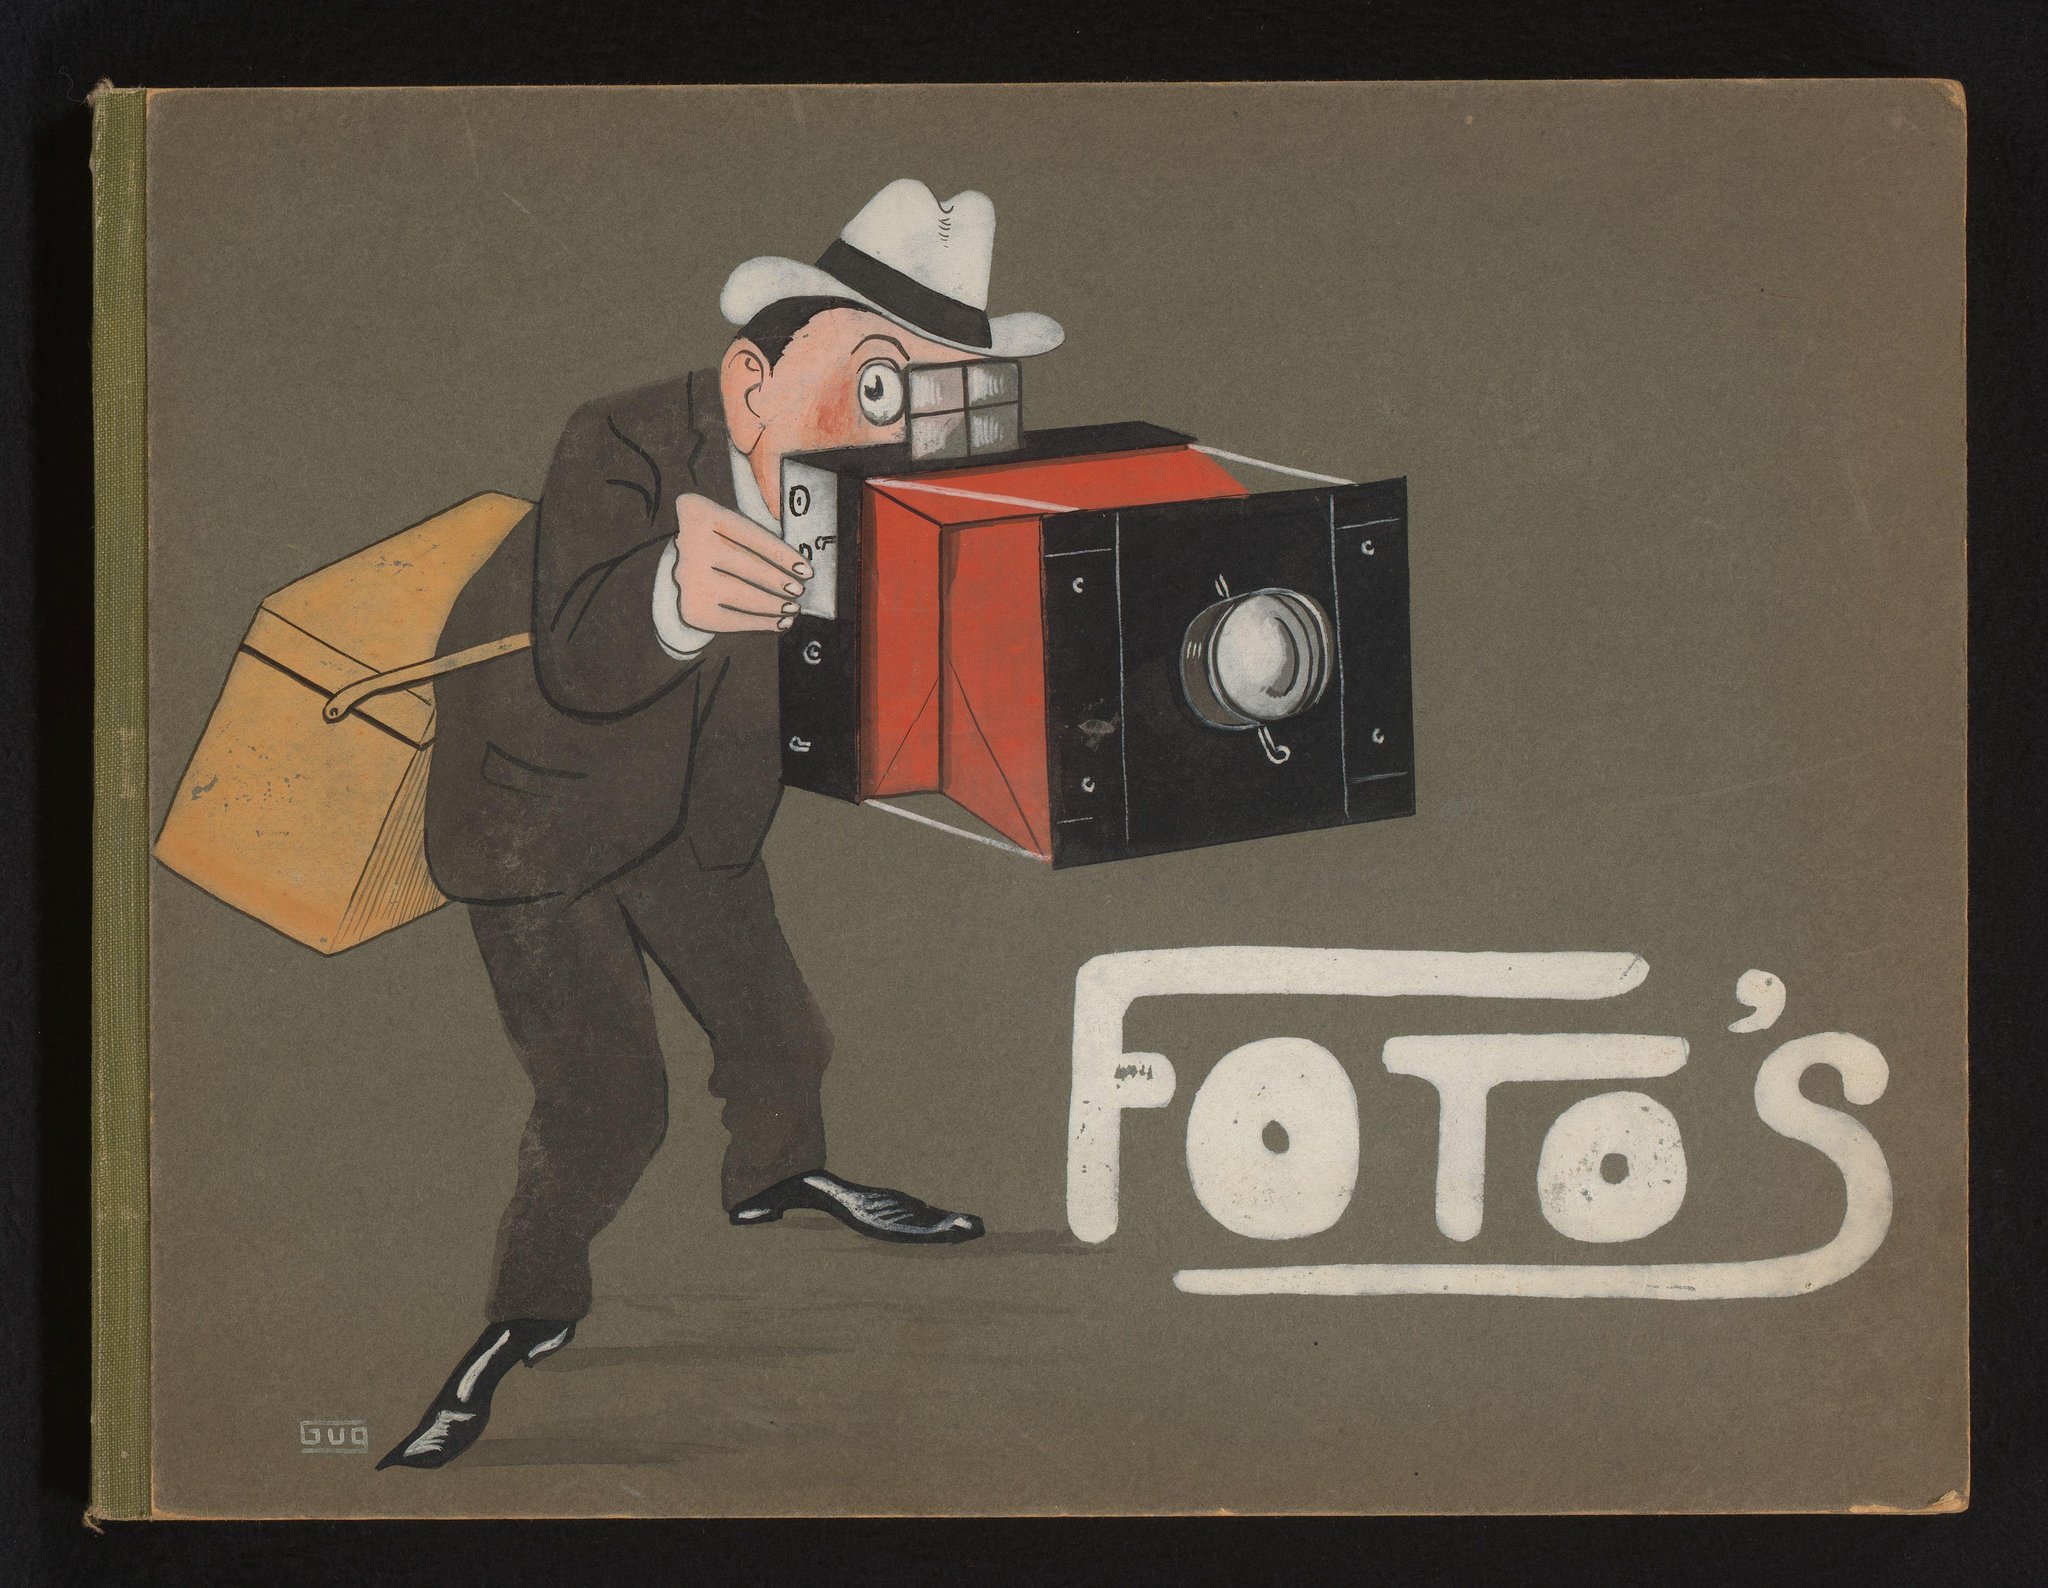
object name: photograph album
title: Reisalbum met 24 foto's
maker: Anonymous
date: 1920-1930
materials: cardboard, linen, paper, photographic support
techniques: decorated paper, gelatin silver print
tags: dale, valley, landscapes, city-view in general; 'veduta', historical persons, rural housing, e.g. country-house, villa, cottage, forest path or lane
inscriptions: inscription: ‘van den getroffene............No. .........U./ SGS. 440.’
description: Fotoalbum met 26 pagina's met in totaal 24 foto's in rechthoekige passe-partouts. Iedere pagina bevat 1 passe-partout. Niet alle passe-partouts zijn gevuld. Afgebeeld zijn landschappen, enkele stadsgezichten en andere buitentaferelen. Op enkele foto's zijn ook mensen afgebeeld. De fotograaf of fotografen is/zijn anoniem.